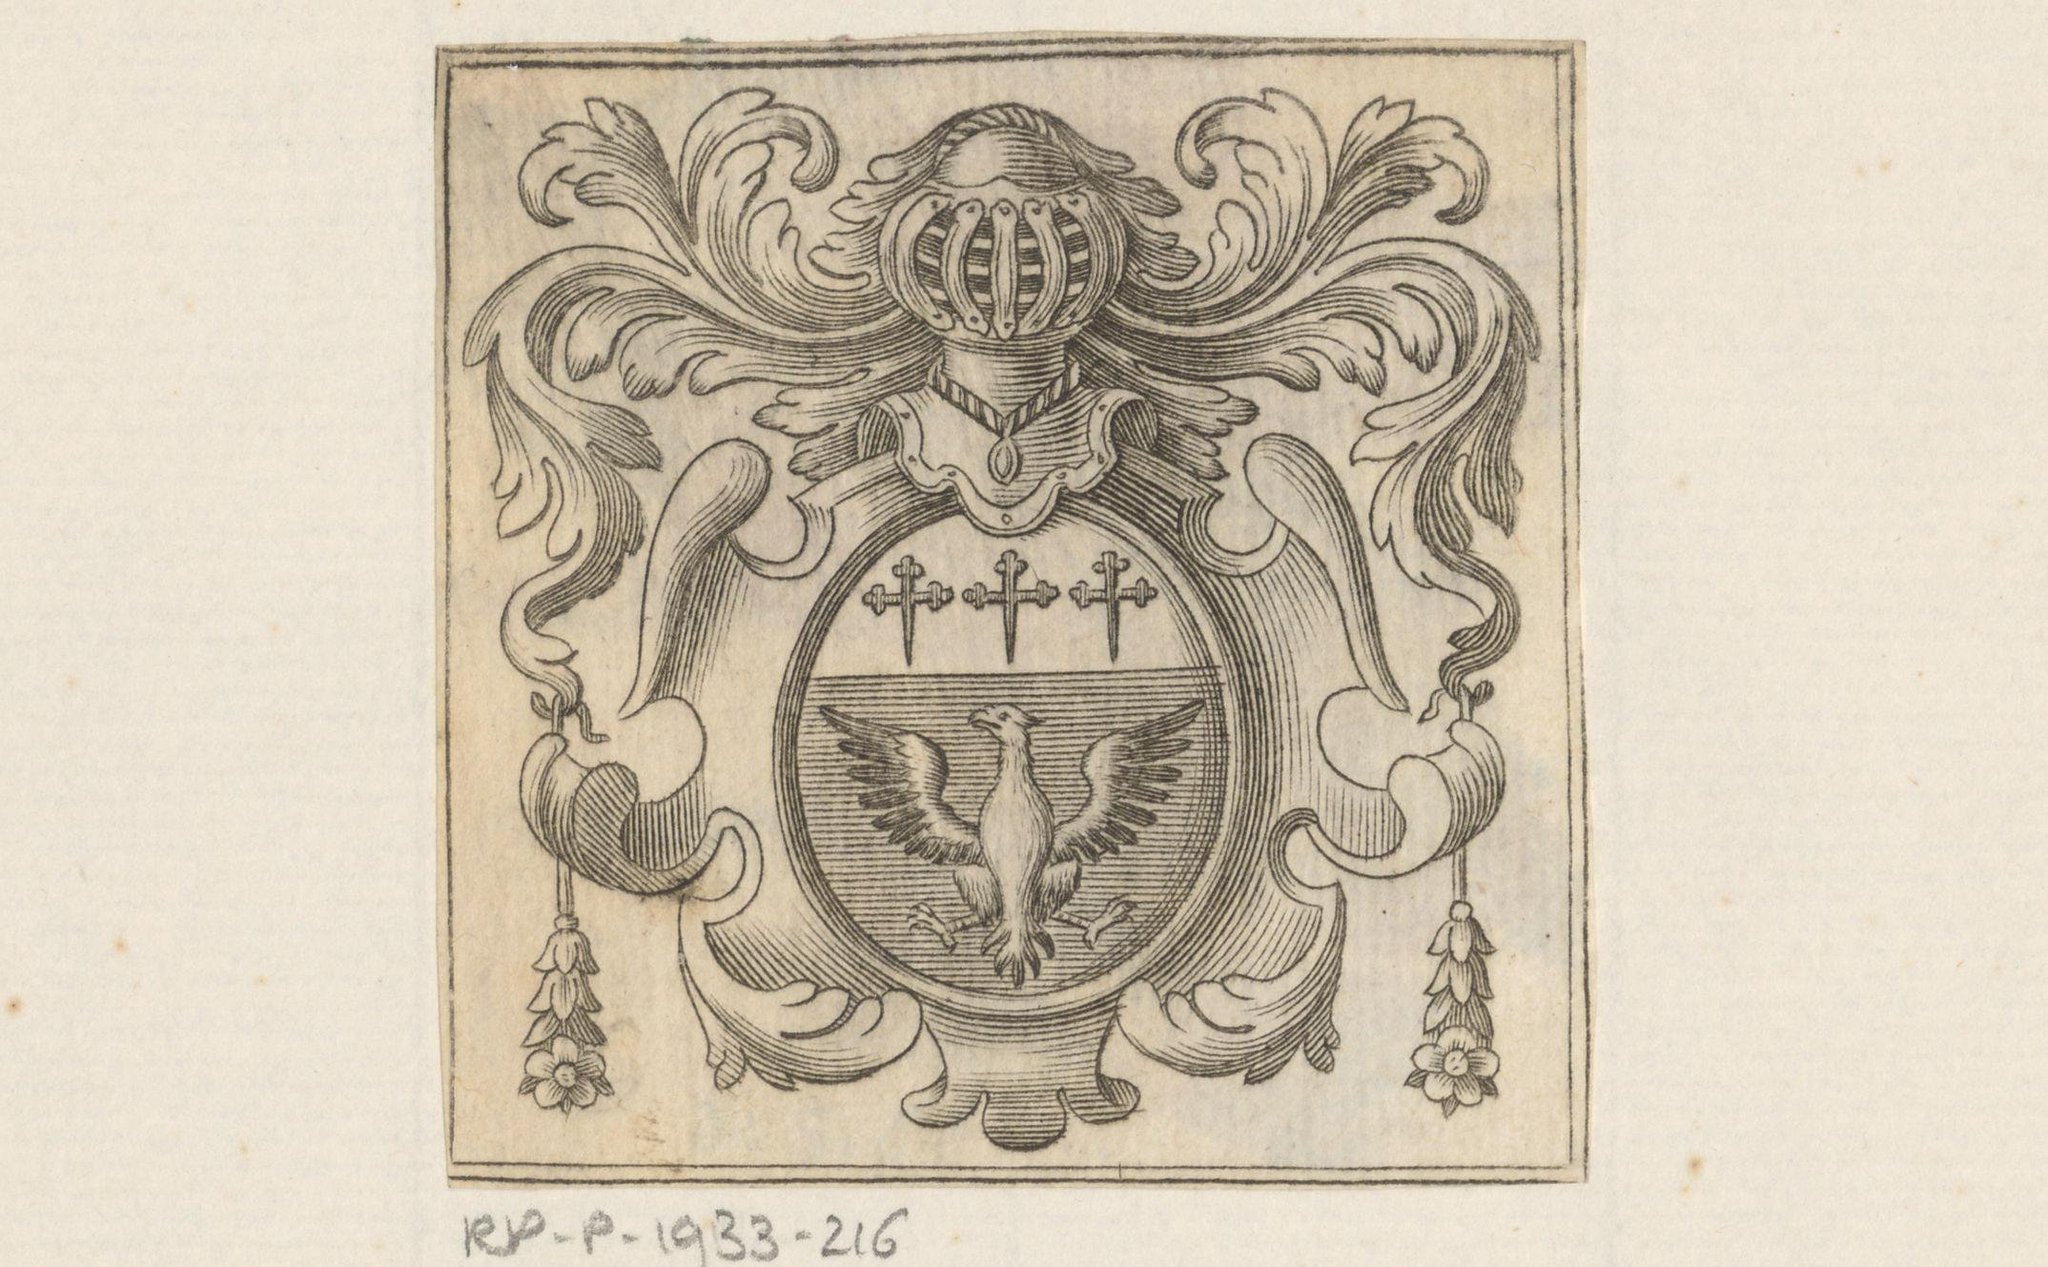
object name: bookplate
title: Ex libris van Cusset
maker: Anonymous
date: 1600-1799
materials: paper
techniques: engraving, etching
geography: france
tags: predatory birds: eagle, armorial bearing, heraldry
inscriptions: collector's mark: Lugt 2233, collector's mark: Lugt 2760